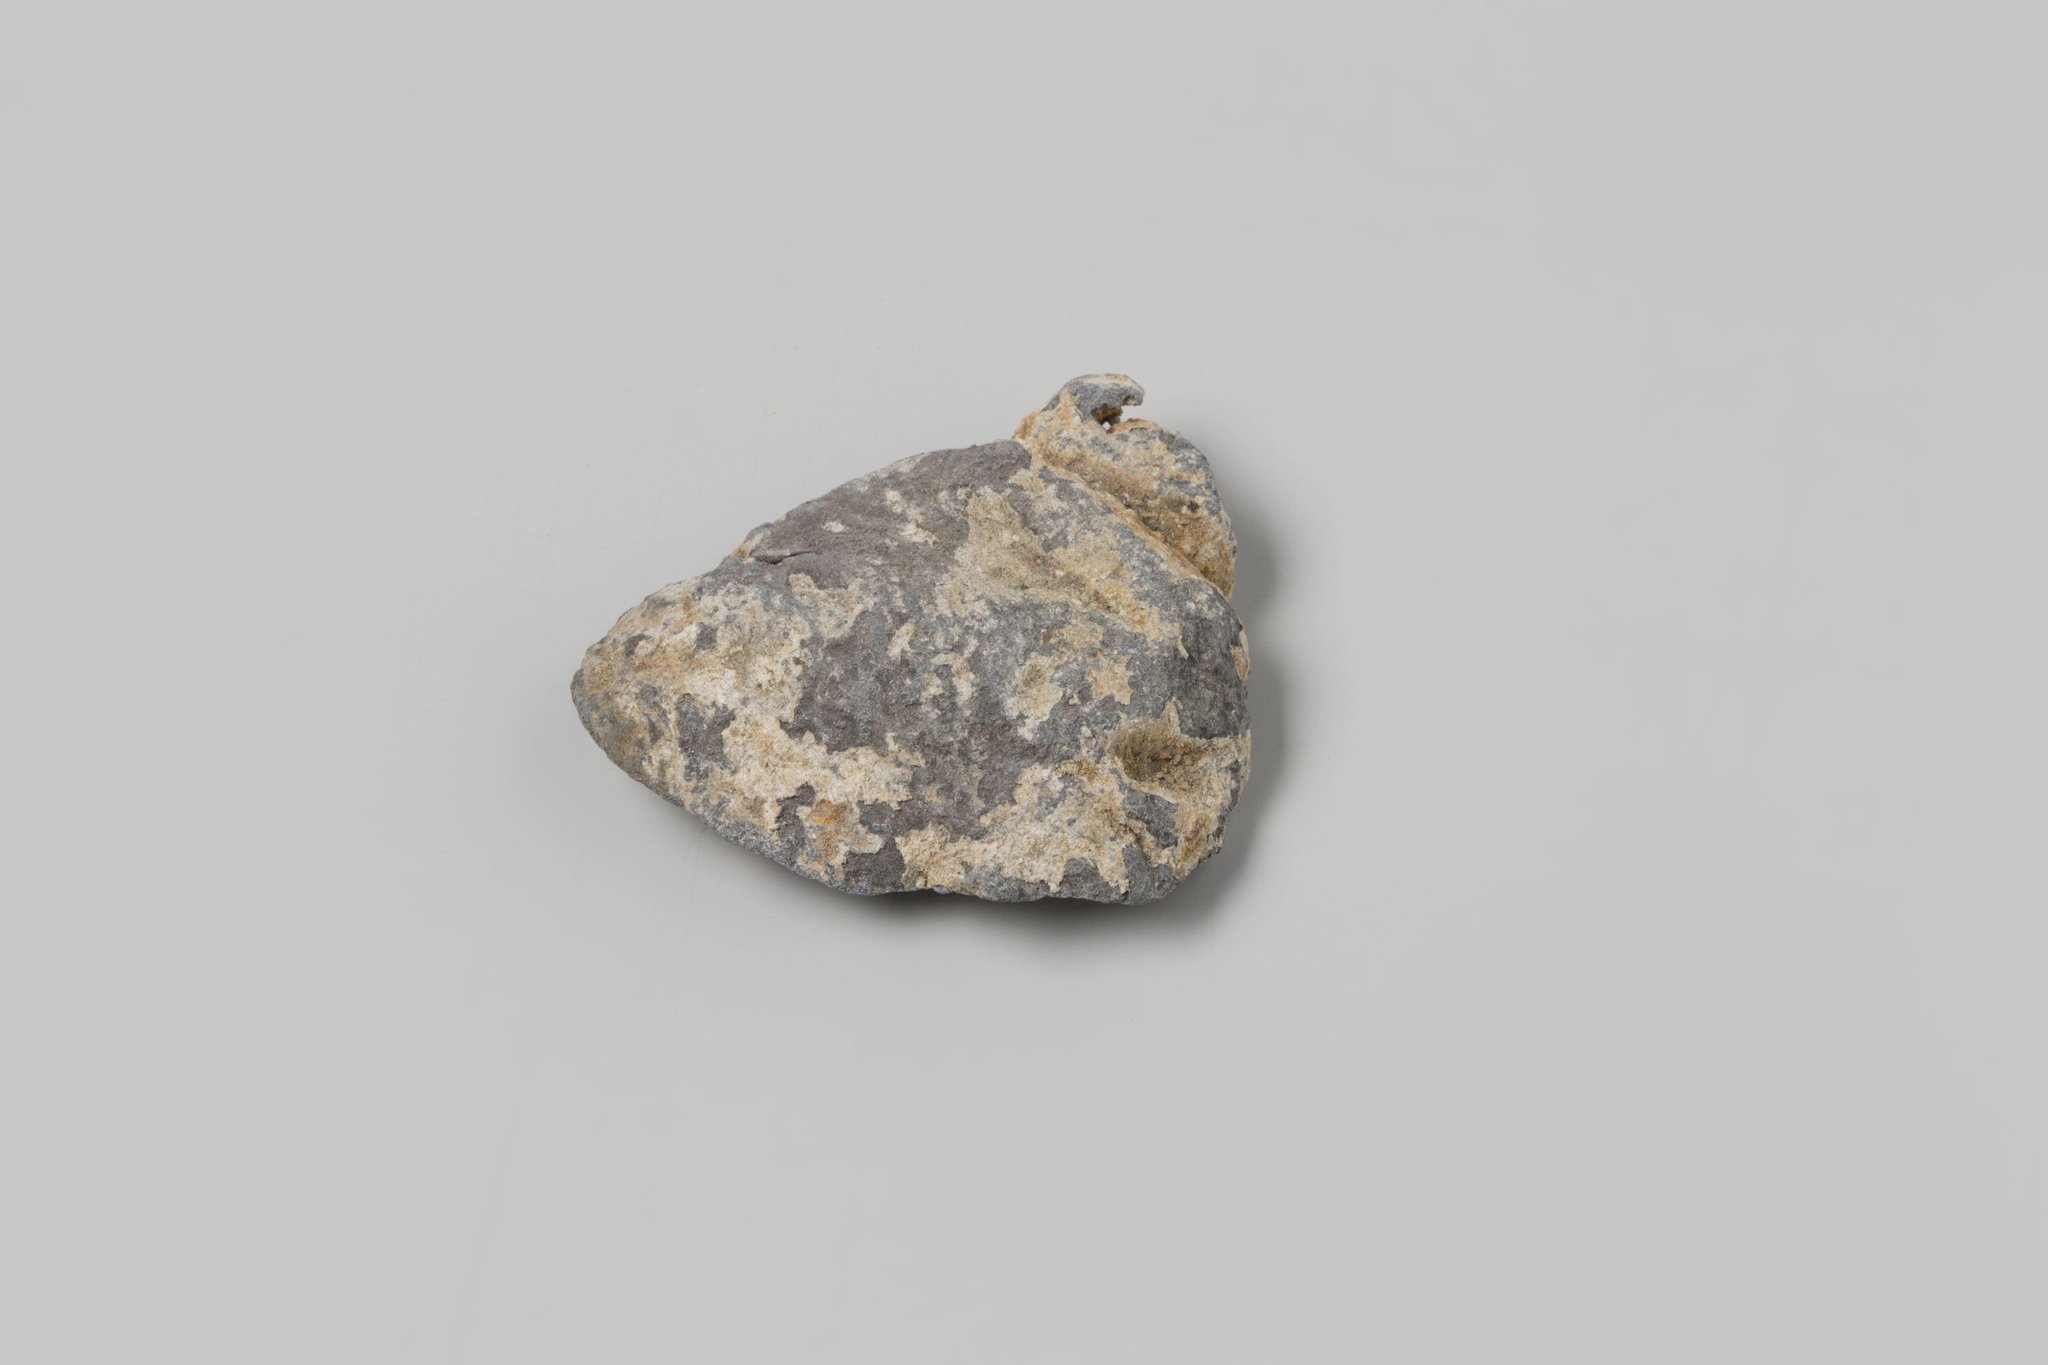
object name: scheepswrakvondst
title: Scheepswrakvondst uit het wrak van de Oost-Indiëvaarder Hollandia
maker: Anonymous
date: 1700-1743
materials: lead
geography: netherlands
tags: verenigde oostindische compagnie, hollandia (schip), annet